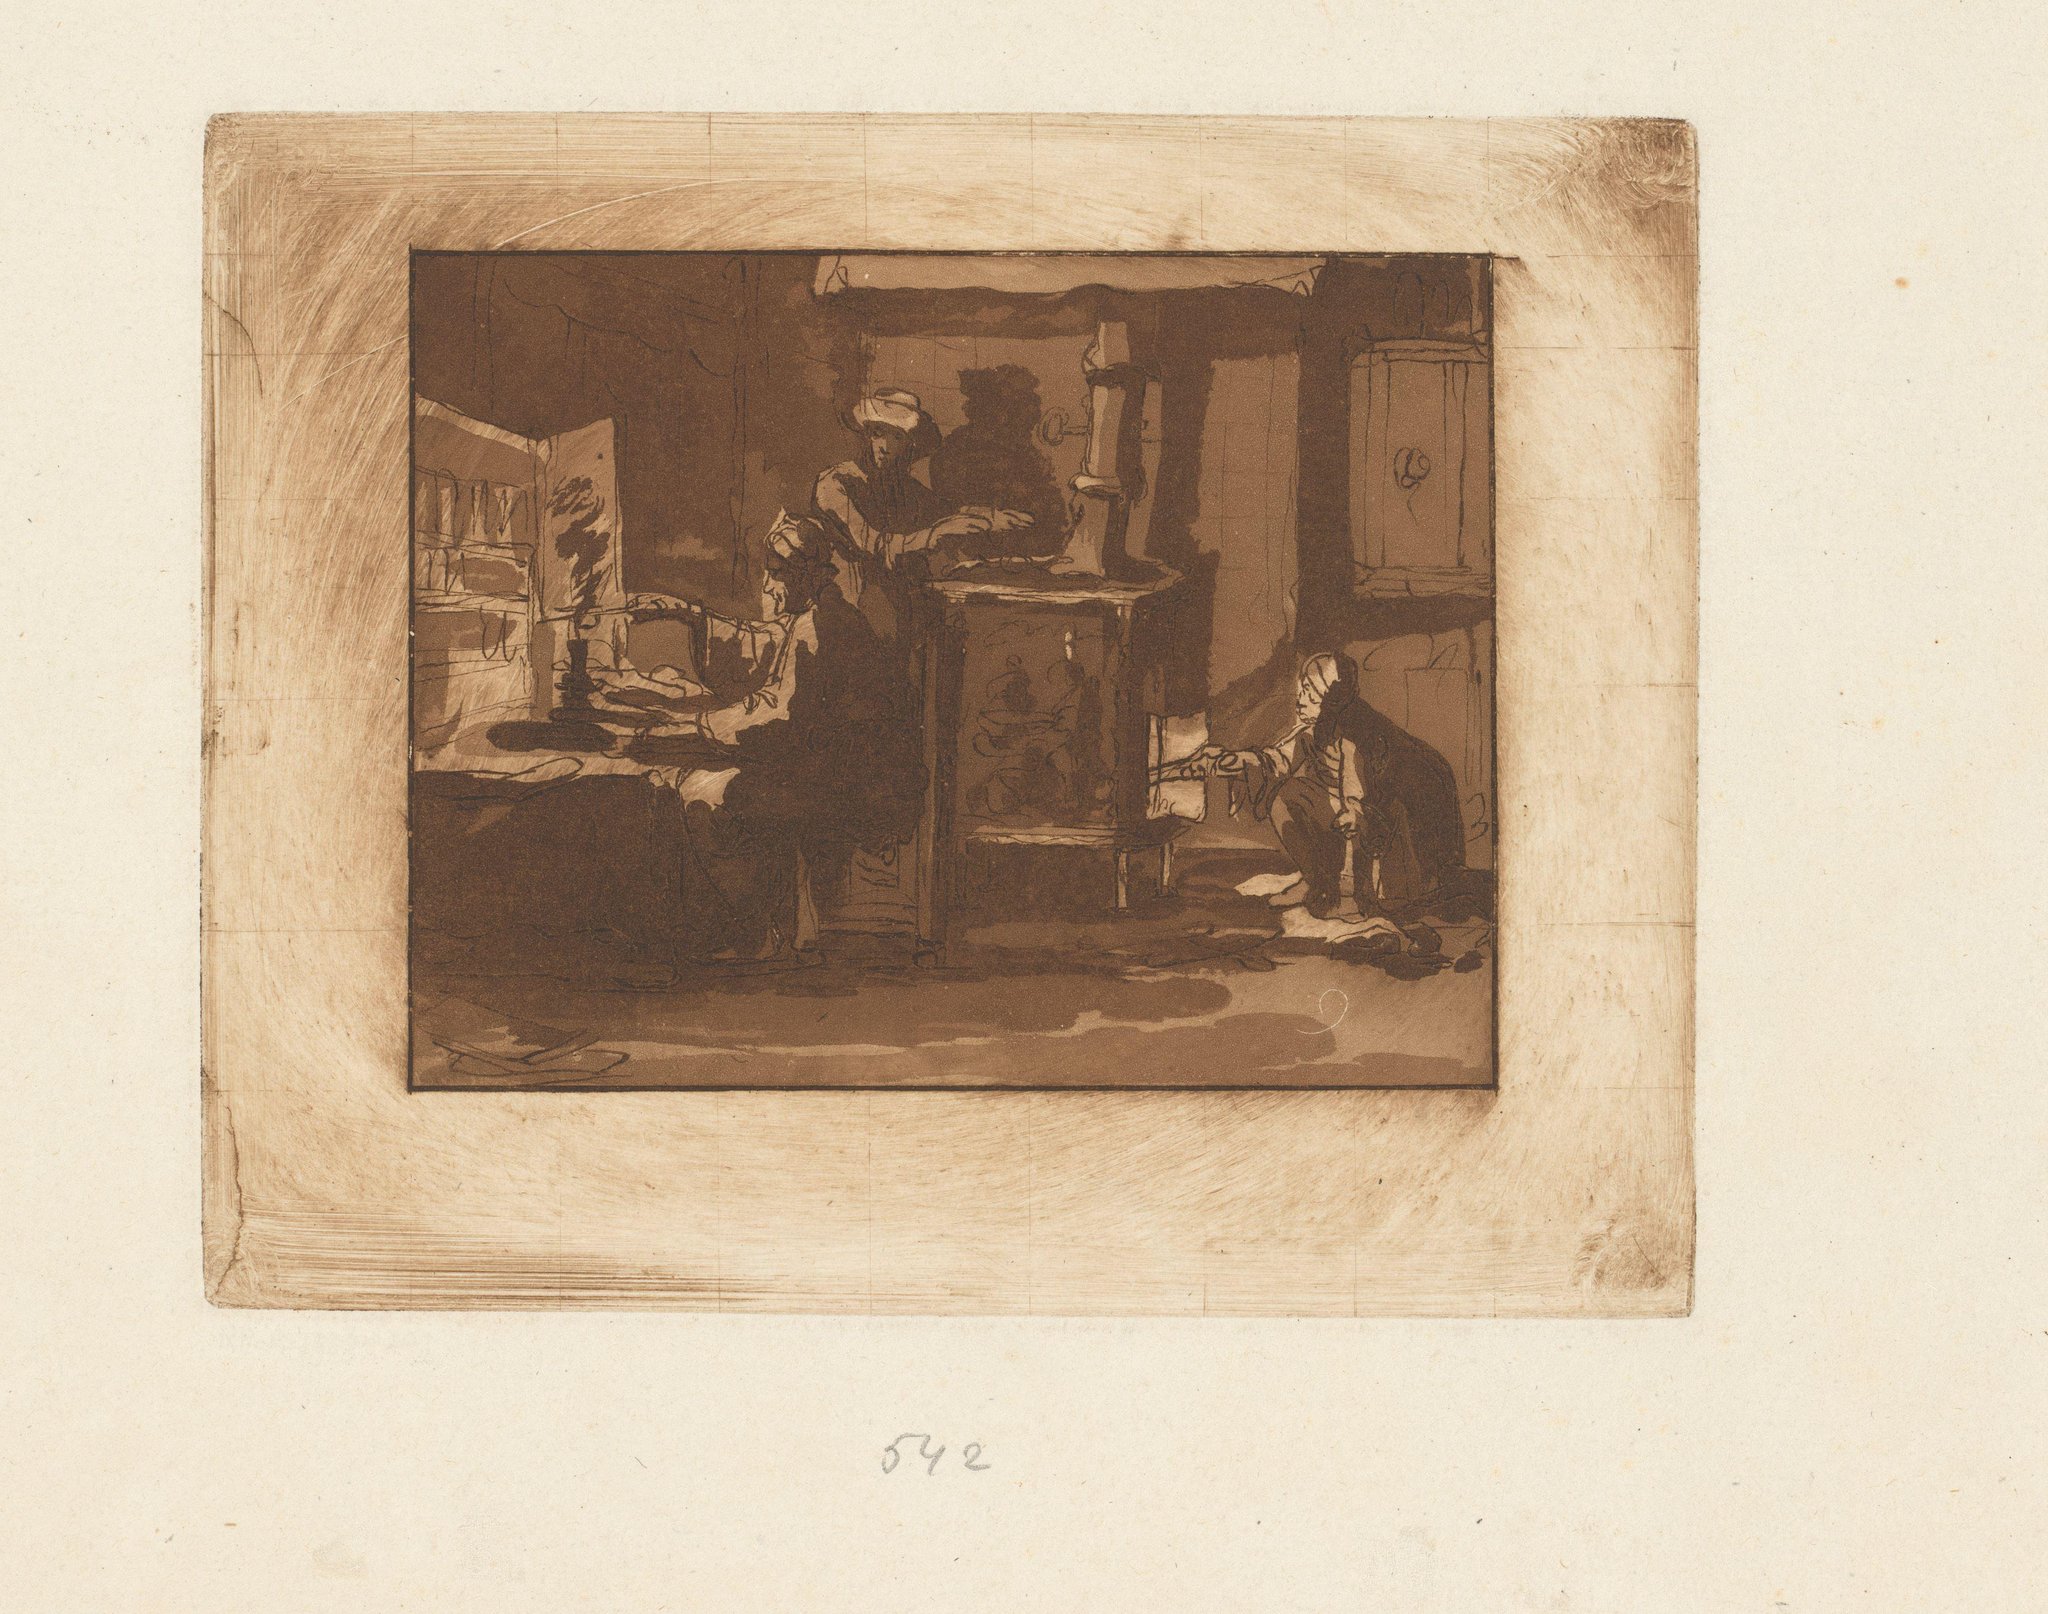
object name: print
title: Kaarssnuitende man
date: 1782-1787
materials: paper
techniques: transfer, print drawing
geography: amsterdam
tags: snuffers, warming oneself at a fire (or hearth, stove, fire-pan, brazier), heating stove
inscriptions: collector's mark: ‘RIJKS / MUSM’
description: Interieur met een zittende man, die een kaars dooft. Bij de kachel een staande man, die zijn handen warmt, en een ander die het vuur opstookt. De prent ligt los in een album, zie blad 45.